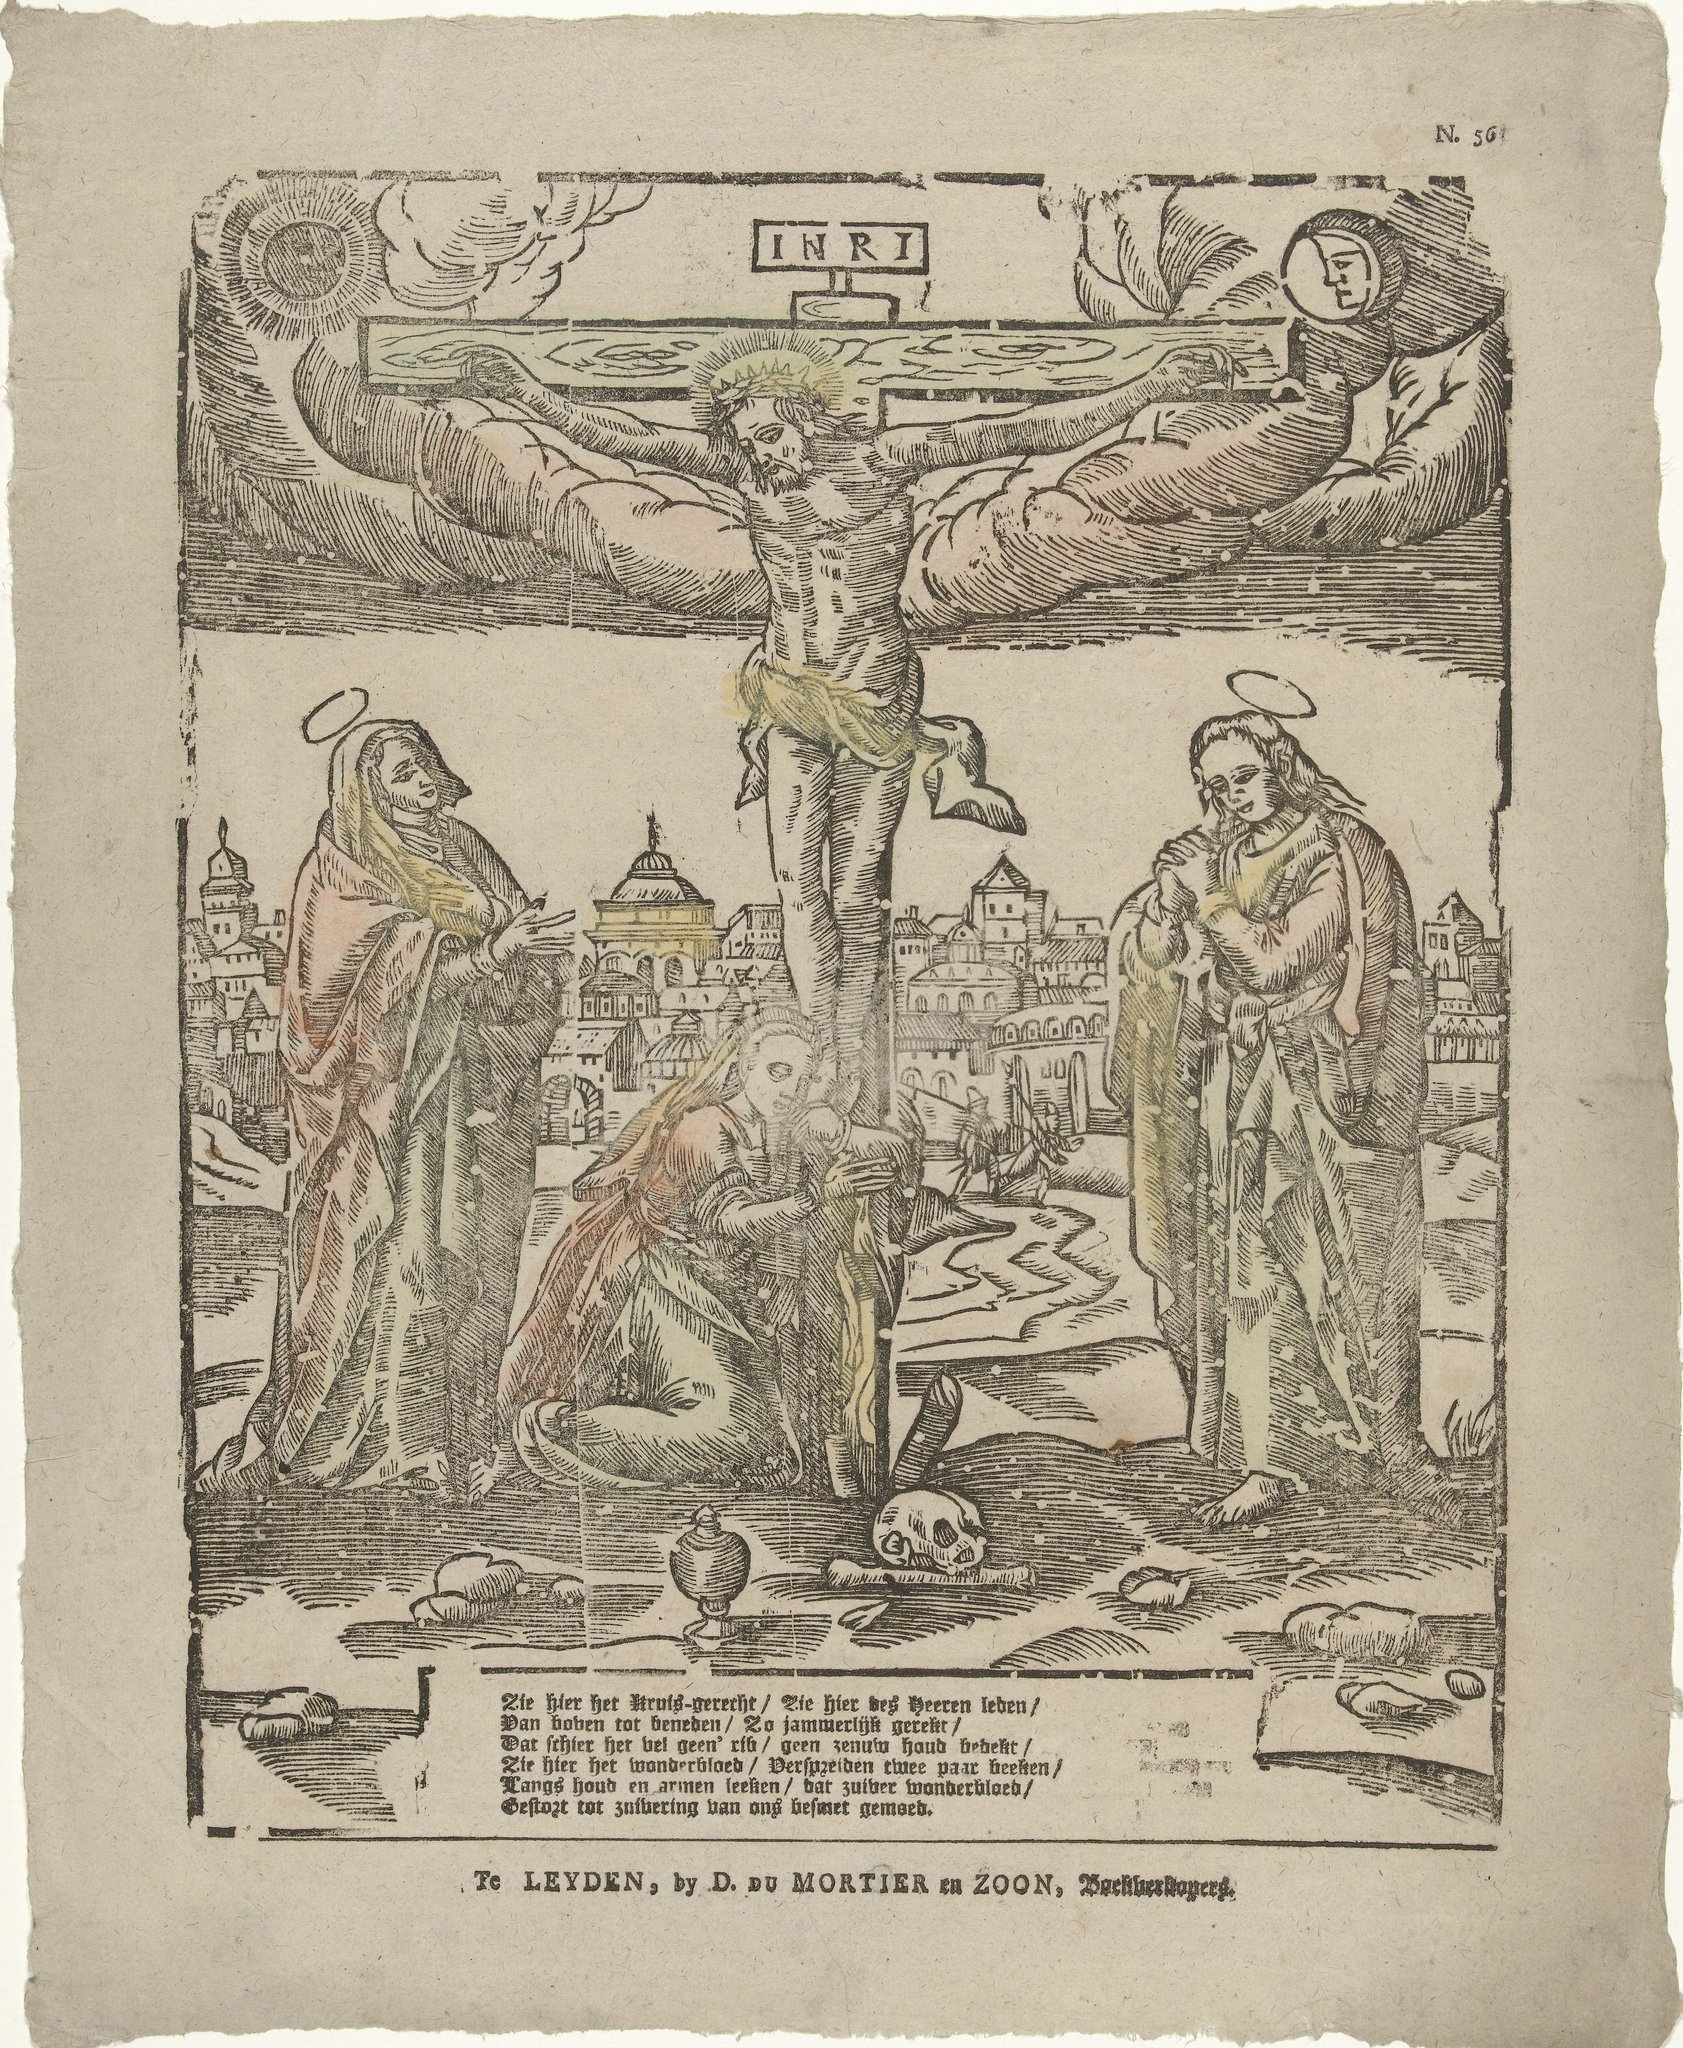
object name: popular print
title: Christus aan het kruis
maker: Anonymous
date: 1550-1650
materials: paper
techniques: colour, letterpress printing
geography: leiden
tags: crucified christ with mary, john, and mary magdalene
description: Christus aan het kruis, met Maria, Johannes en Maria Magdalena. In het onderschrift een vers van zes regels. Genummerd rechtsboven: N. 56.